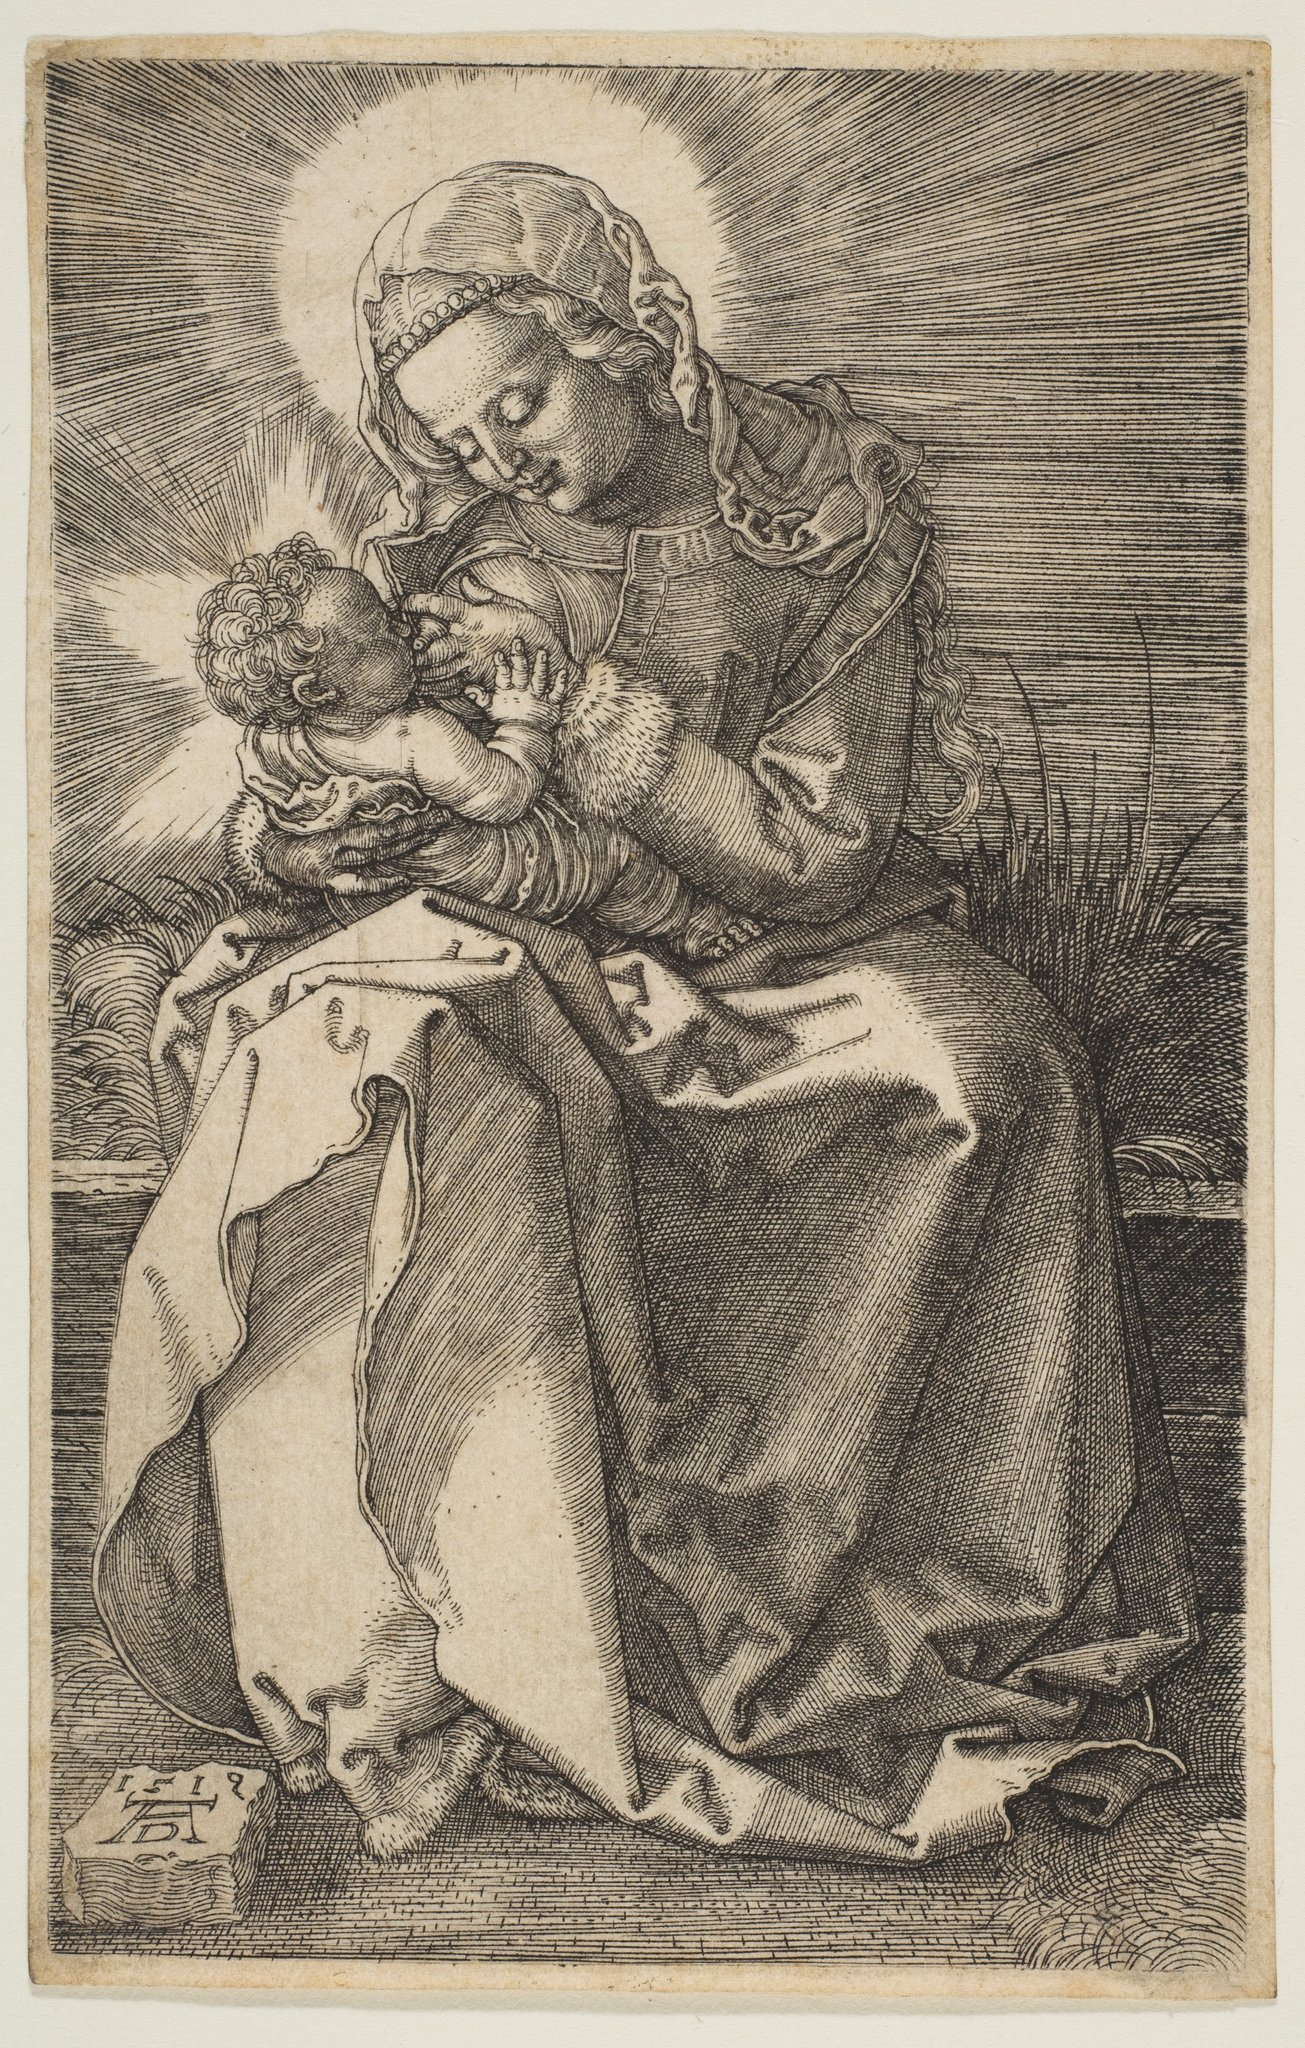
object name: print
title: The Virgin Nursing the Child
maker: albrecht dürer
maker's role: artist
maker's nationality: german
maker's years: 1471-1528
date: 1519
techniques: engraving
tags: madonna and child